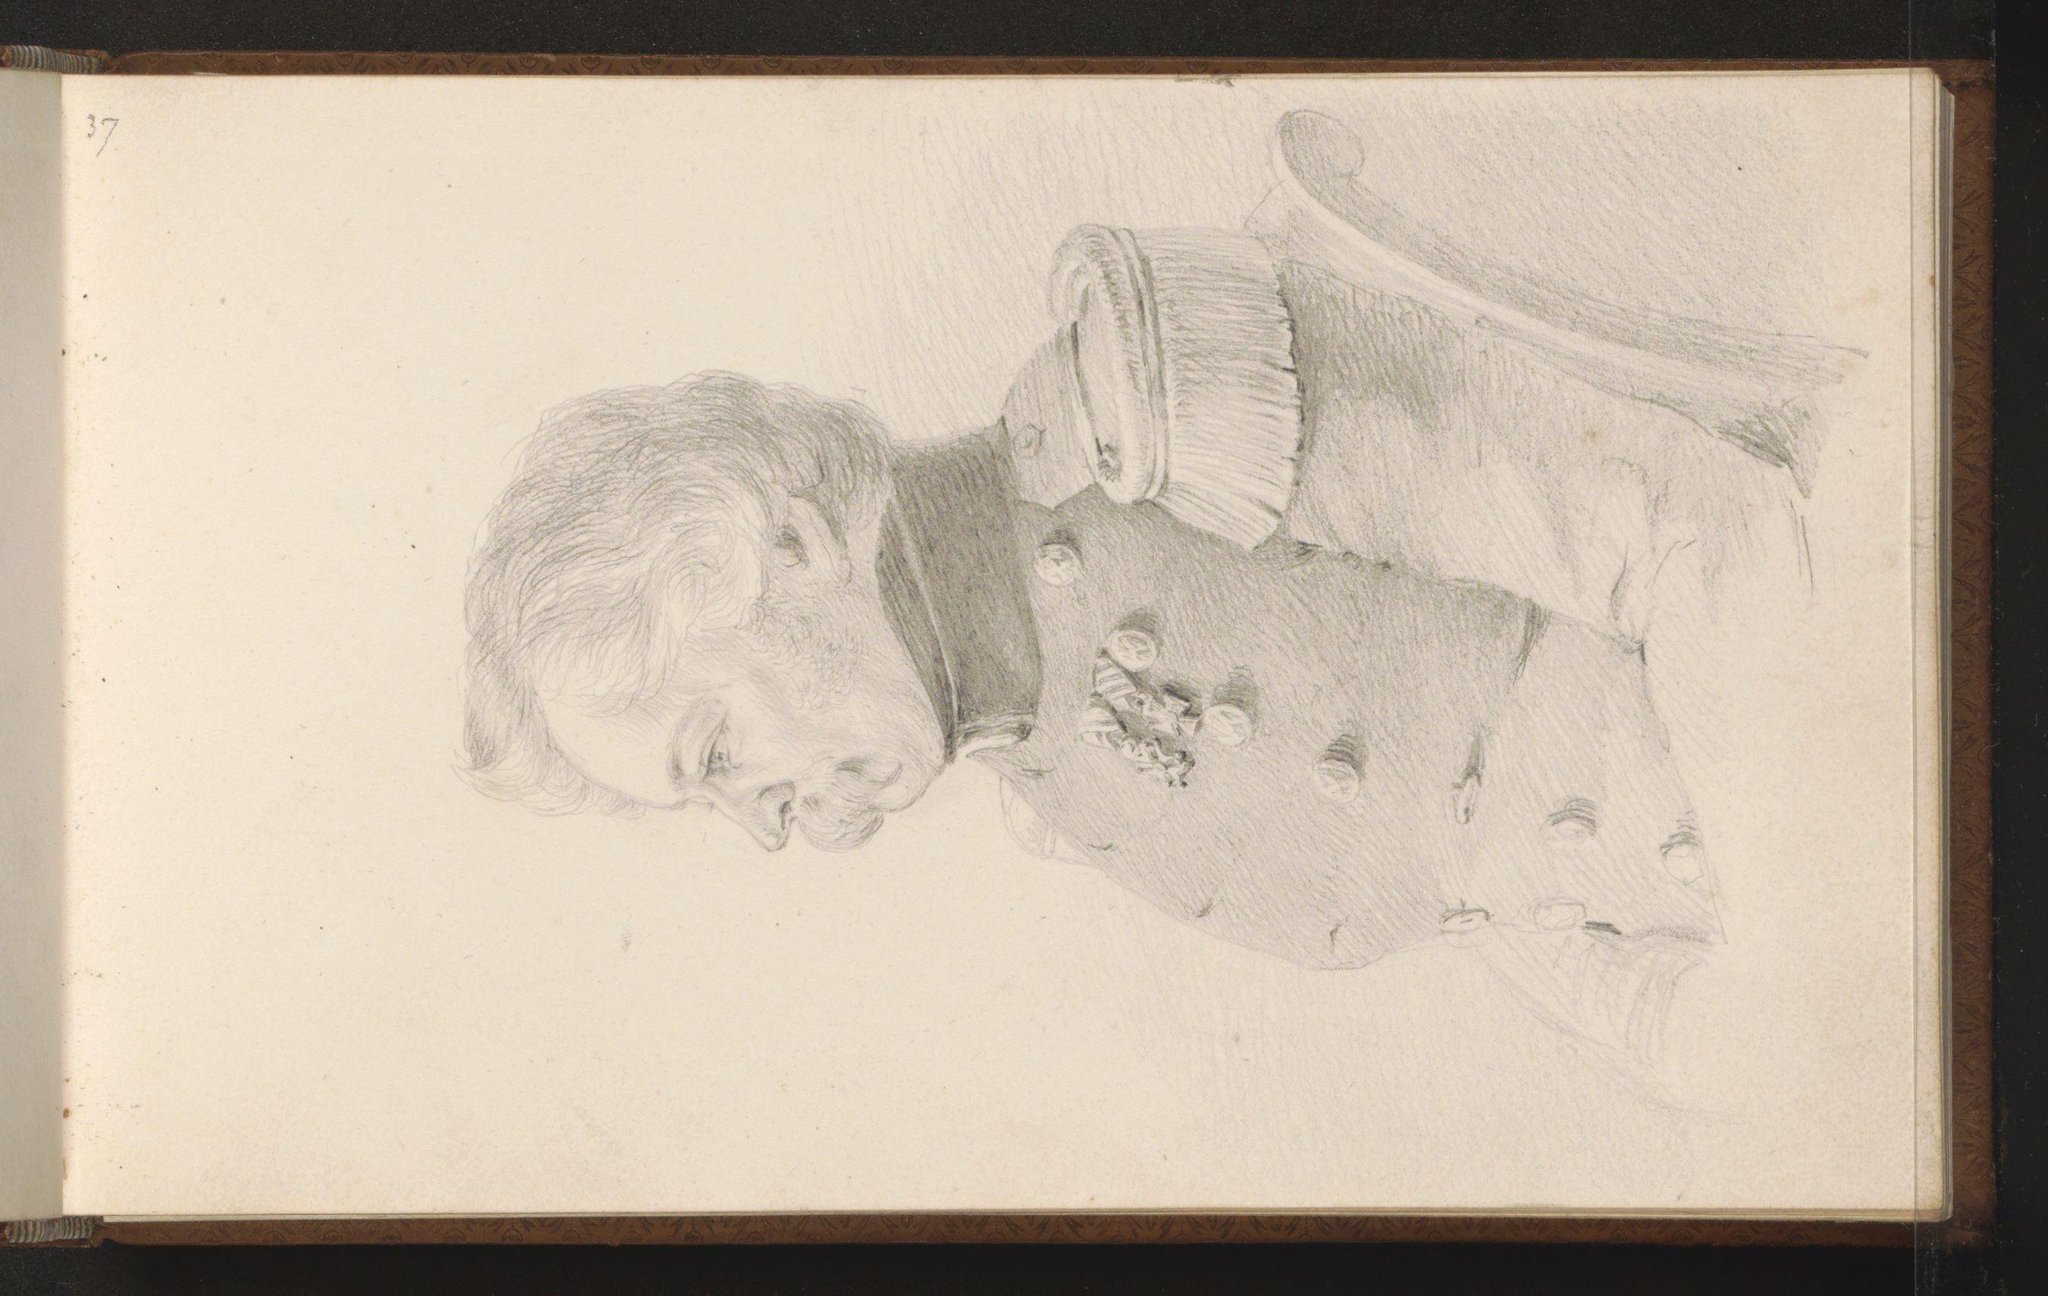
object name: sketchbook leaf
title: Portret van een zittende militair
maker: christian heinrich gottlieb steuerwald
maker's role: draughtsman, print maker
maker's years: 1802-1874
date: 1834-1844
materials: paper, pencil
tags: (military) uniforms, historical persons (portraits and scenes from the life)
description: Bladzijde 37 uit een schetsboek met 188 bladzijden.